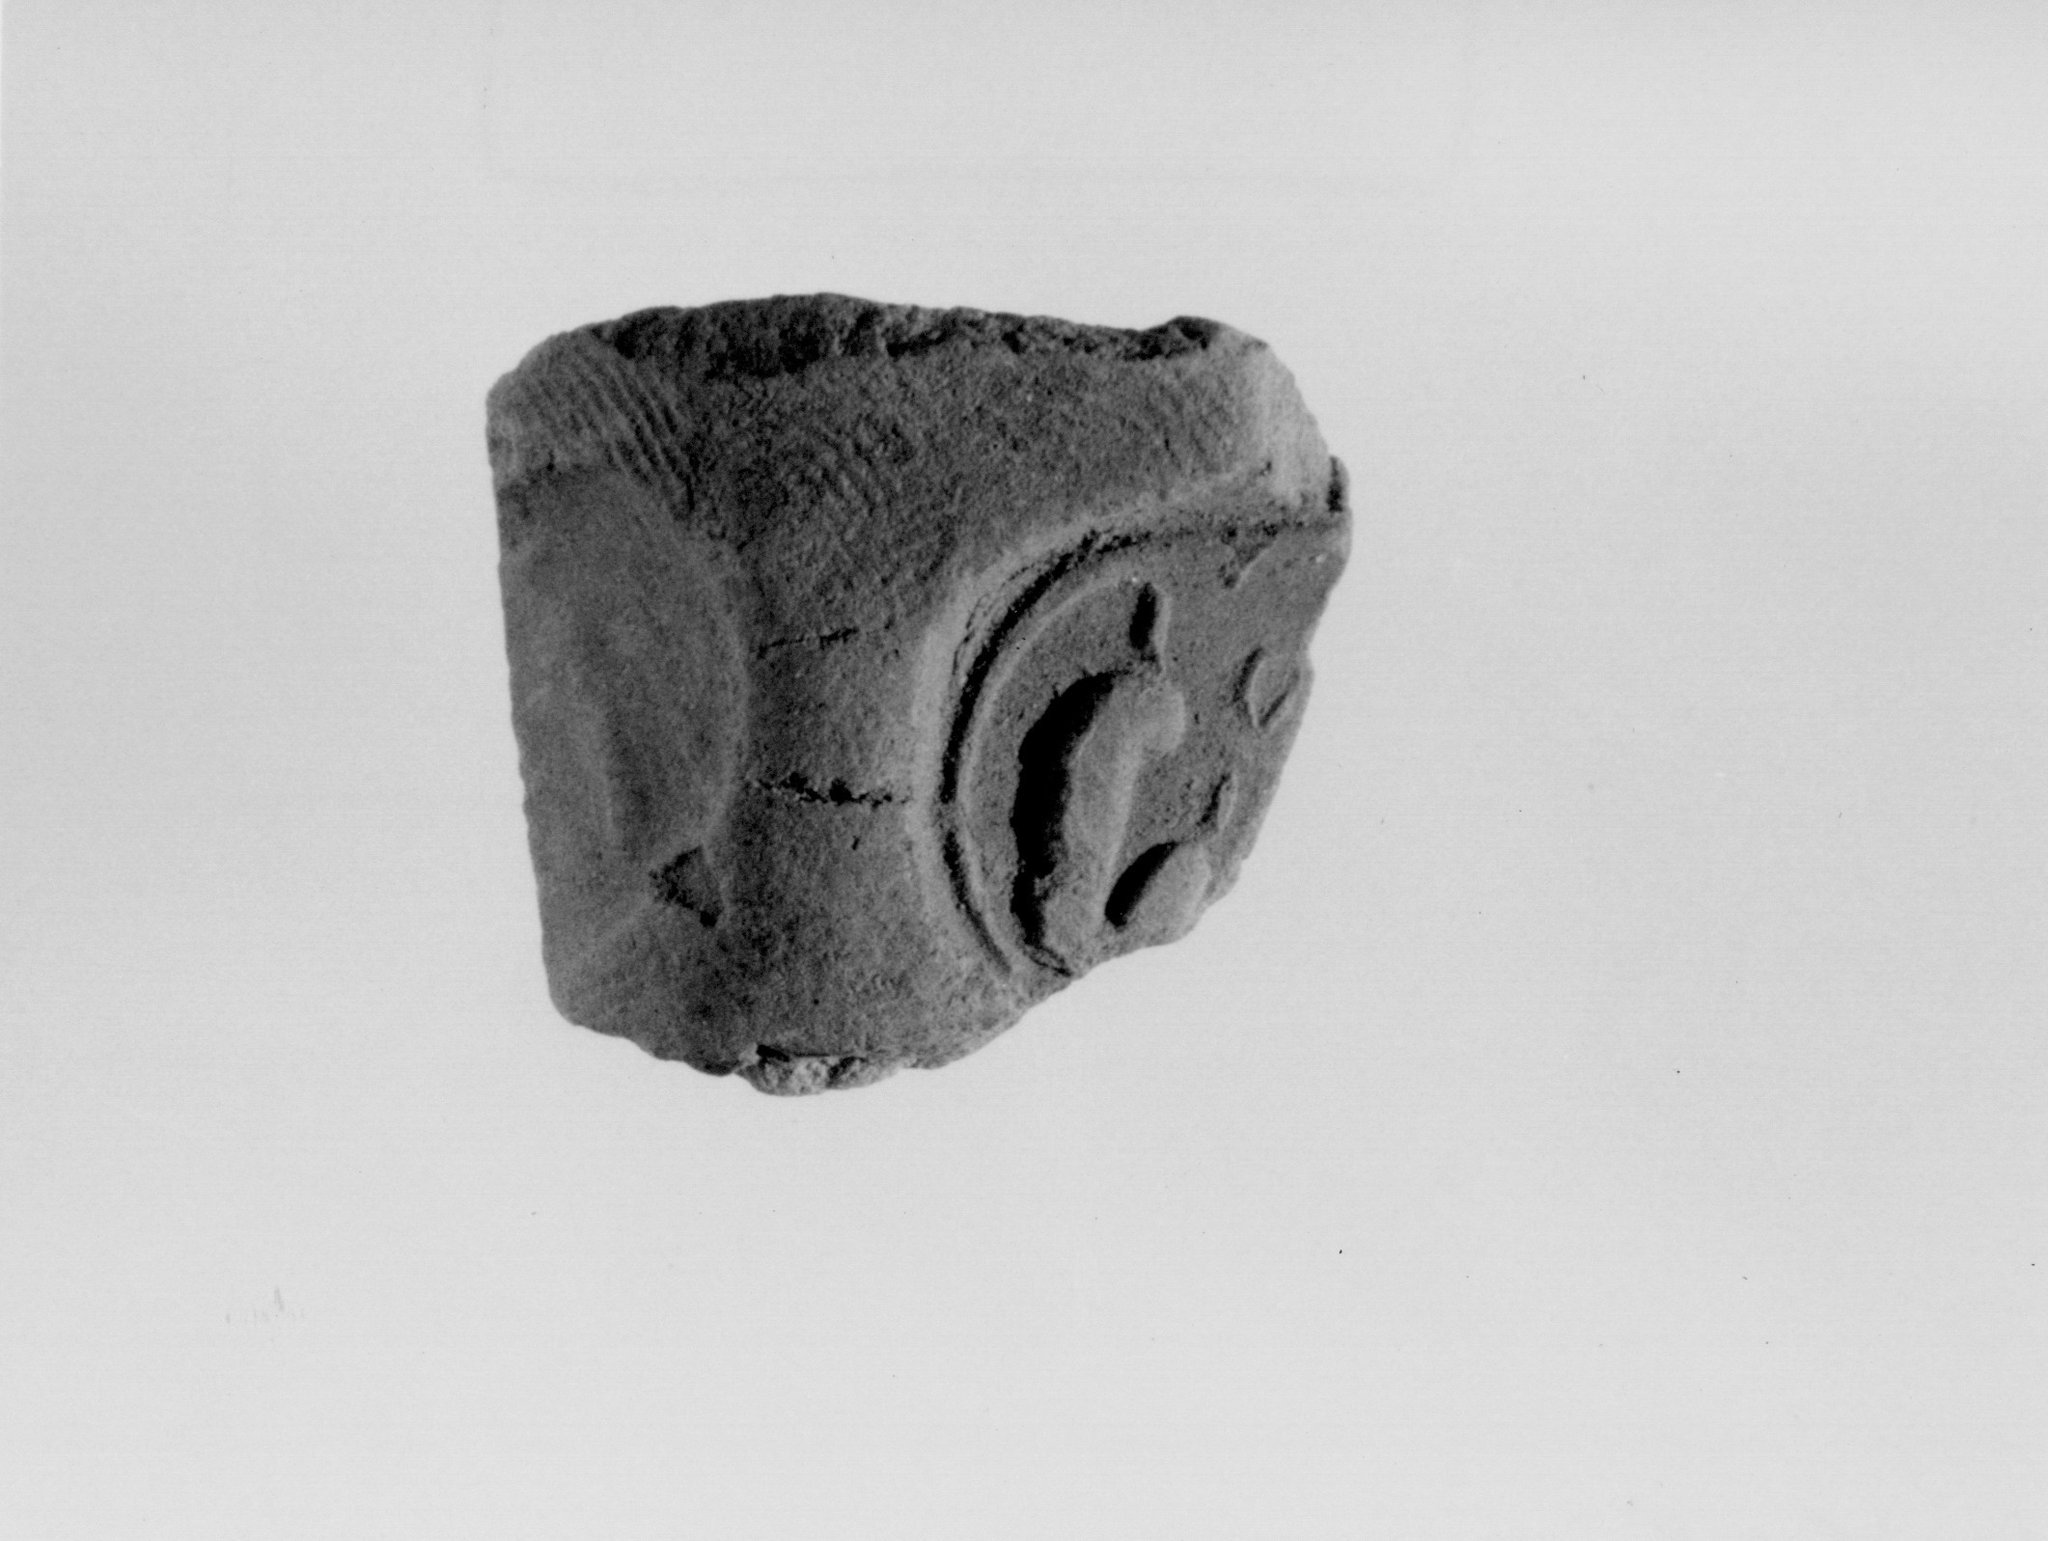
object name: sealing, nebmaatre, amenhotep iii,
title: Document Sealing With the Throne Name of Amenhotep III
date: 1390-1352 BCE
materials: mud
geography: egypt